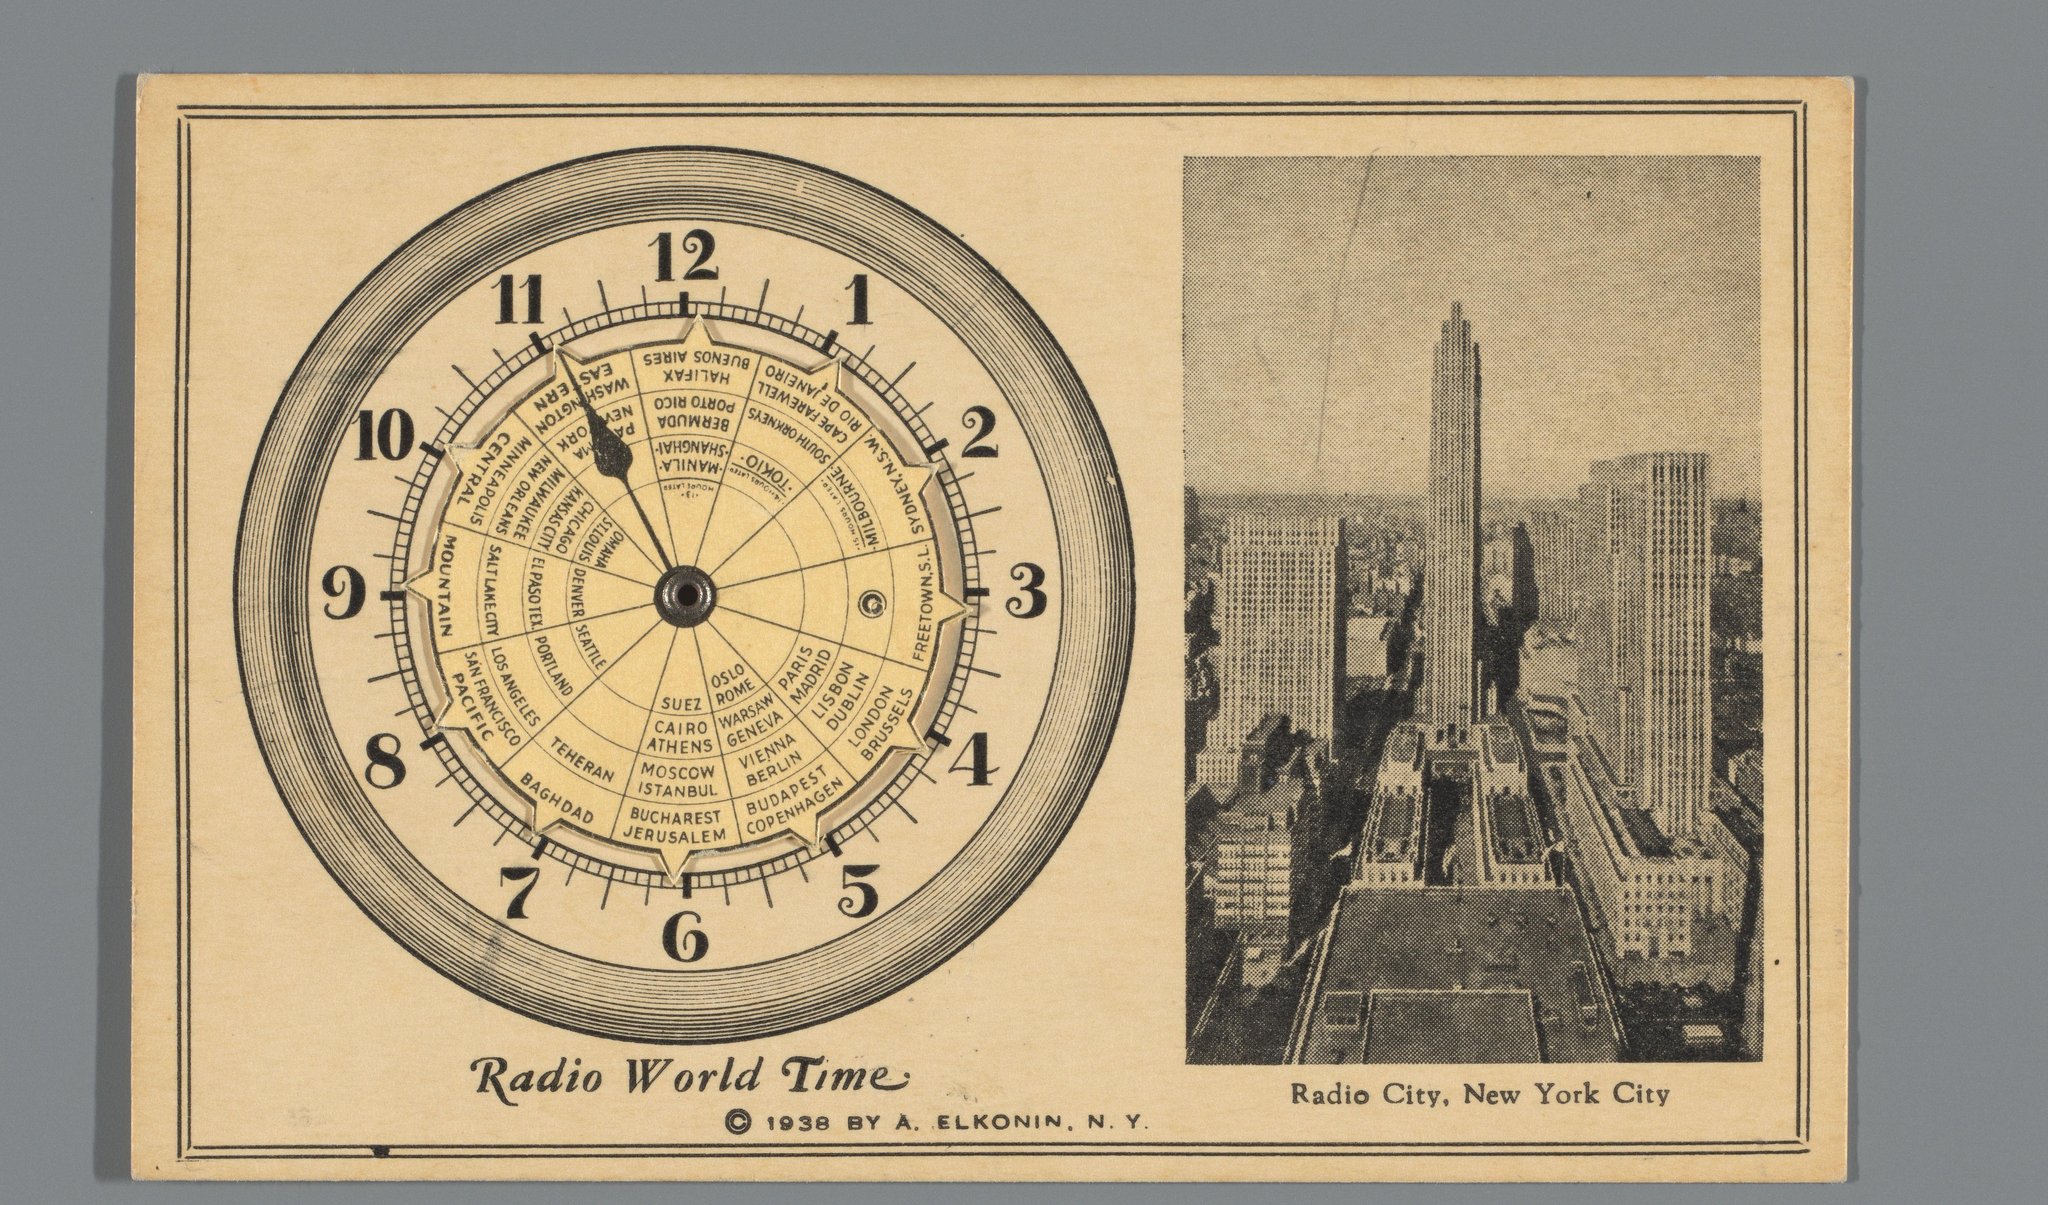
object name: ansichtkaart, prentbriefkaart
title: Reclame met een draaischijf om de uitzendtijd van de radio om te rekenen naar lokale tijd en met een afbeelding van het RCA Building in New York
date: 1938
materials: photographic support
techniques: autotype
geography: new york city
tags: rockefeller center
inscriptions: inscription: ‘Radio World Time / ©1938 BY A. ELKONIN, N. Y. / Radio City, New York City’, inscription: ‘[gebruiksaanwijzingen voor de draaischijf] / THE UNION NEWS COMPANY’